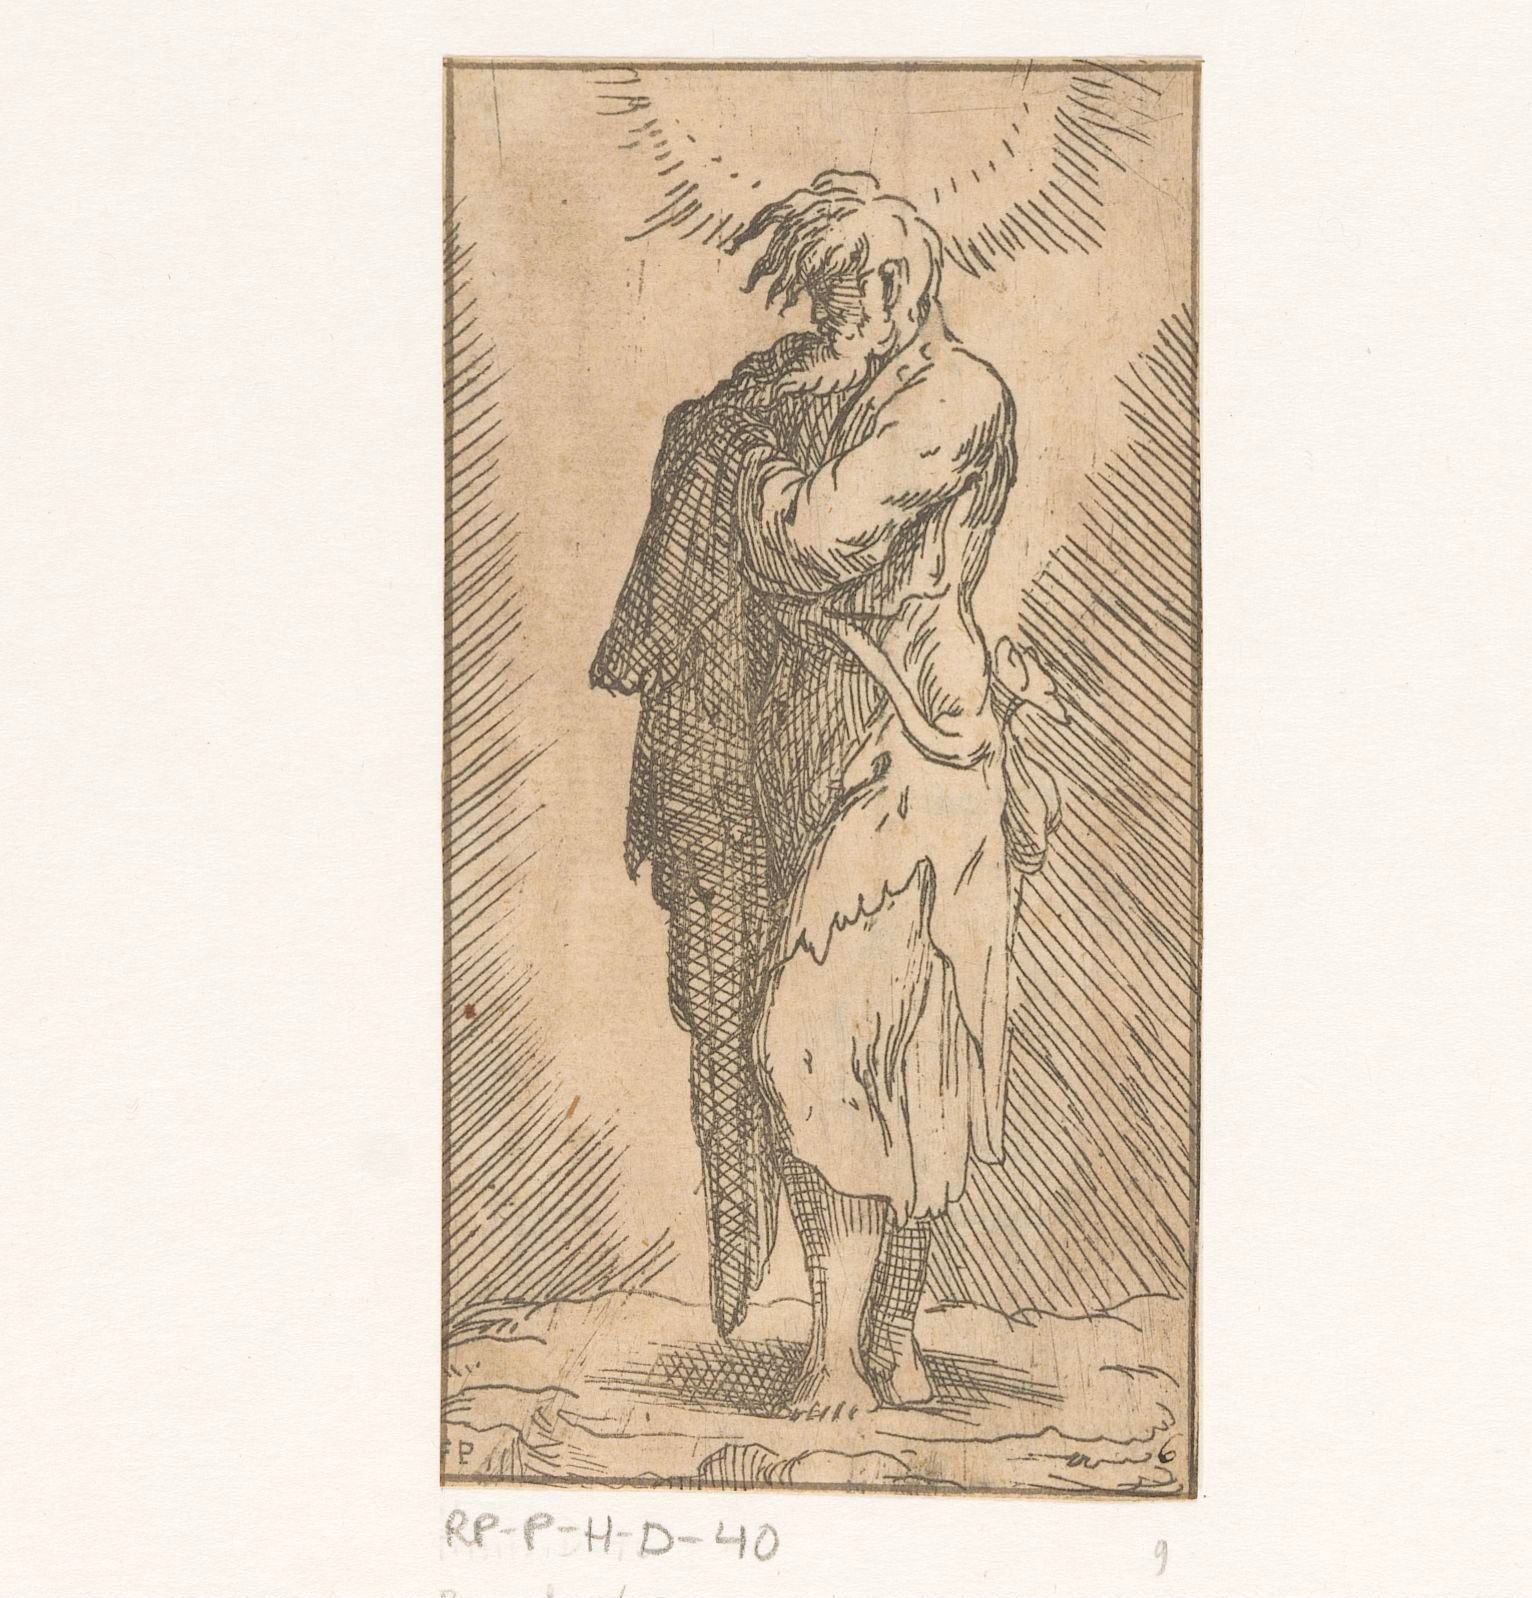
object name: print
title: Christus en de apostelen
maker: monogrammist fp (italië; 16e eeuw)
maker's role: print maker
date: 1500-1599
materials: paper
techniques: etching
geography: italy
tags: the apostle james the less, first bishop of jerusalem; possible attributes: book, fuller's club, scroll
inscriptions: collector's mark: ‘Hinloopen’, number: ‘6’, collector's mark: Lugt 10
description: Deze prent maakt deel uit van een reeks van dertien prenten van Christus en de twaalf apostelen.